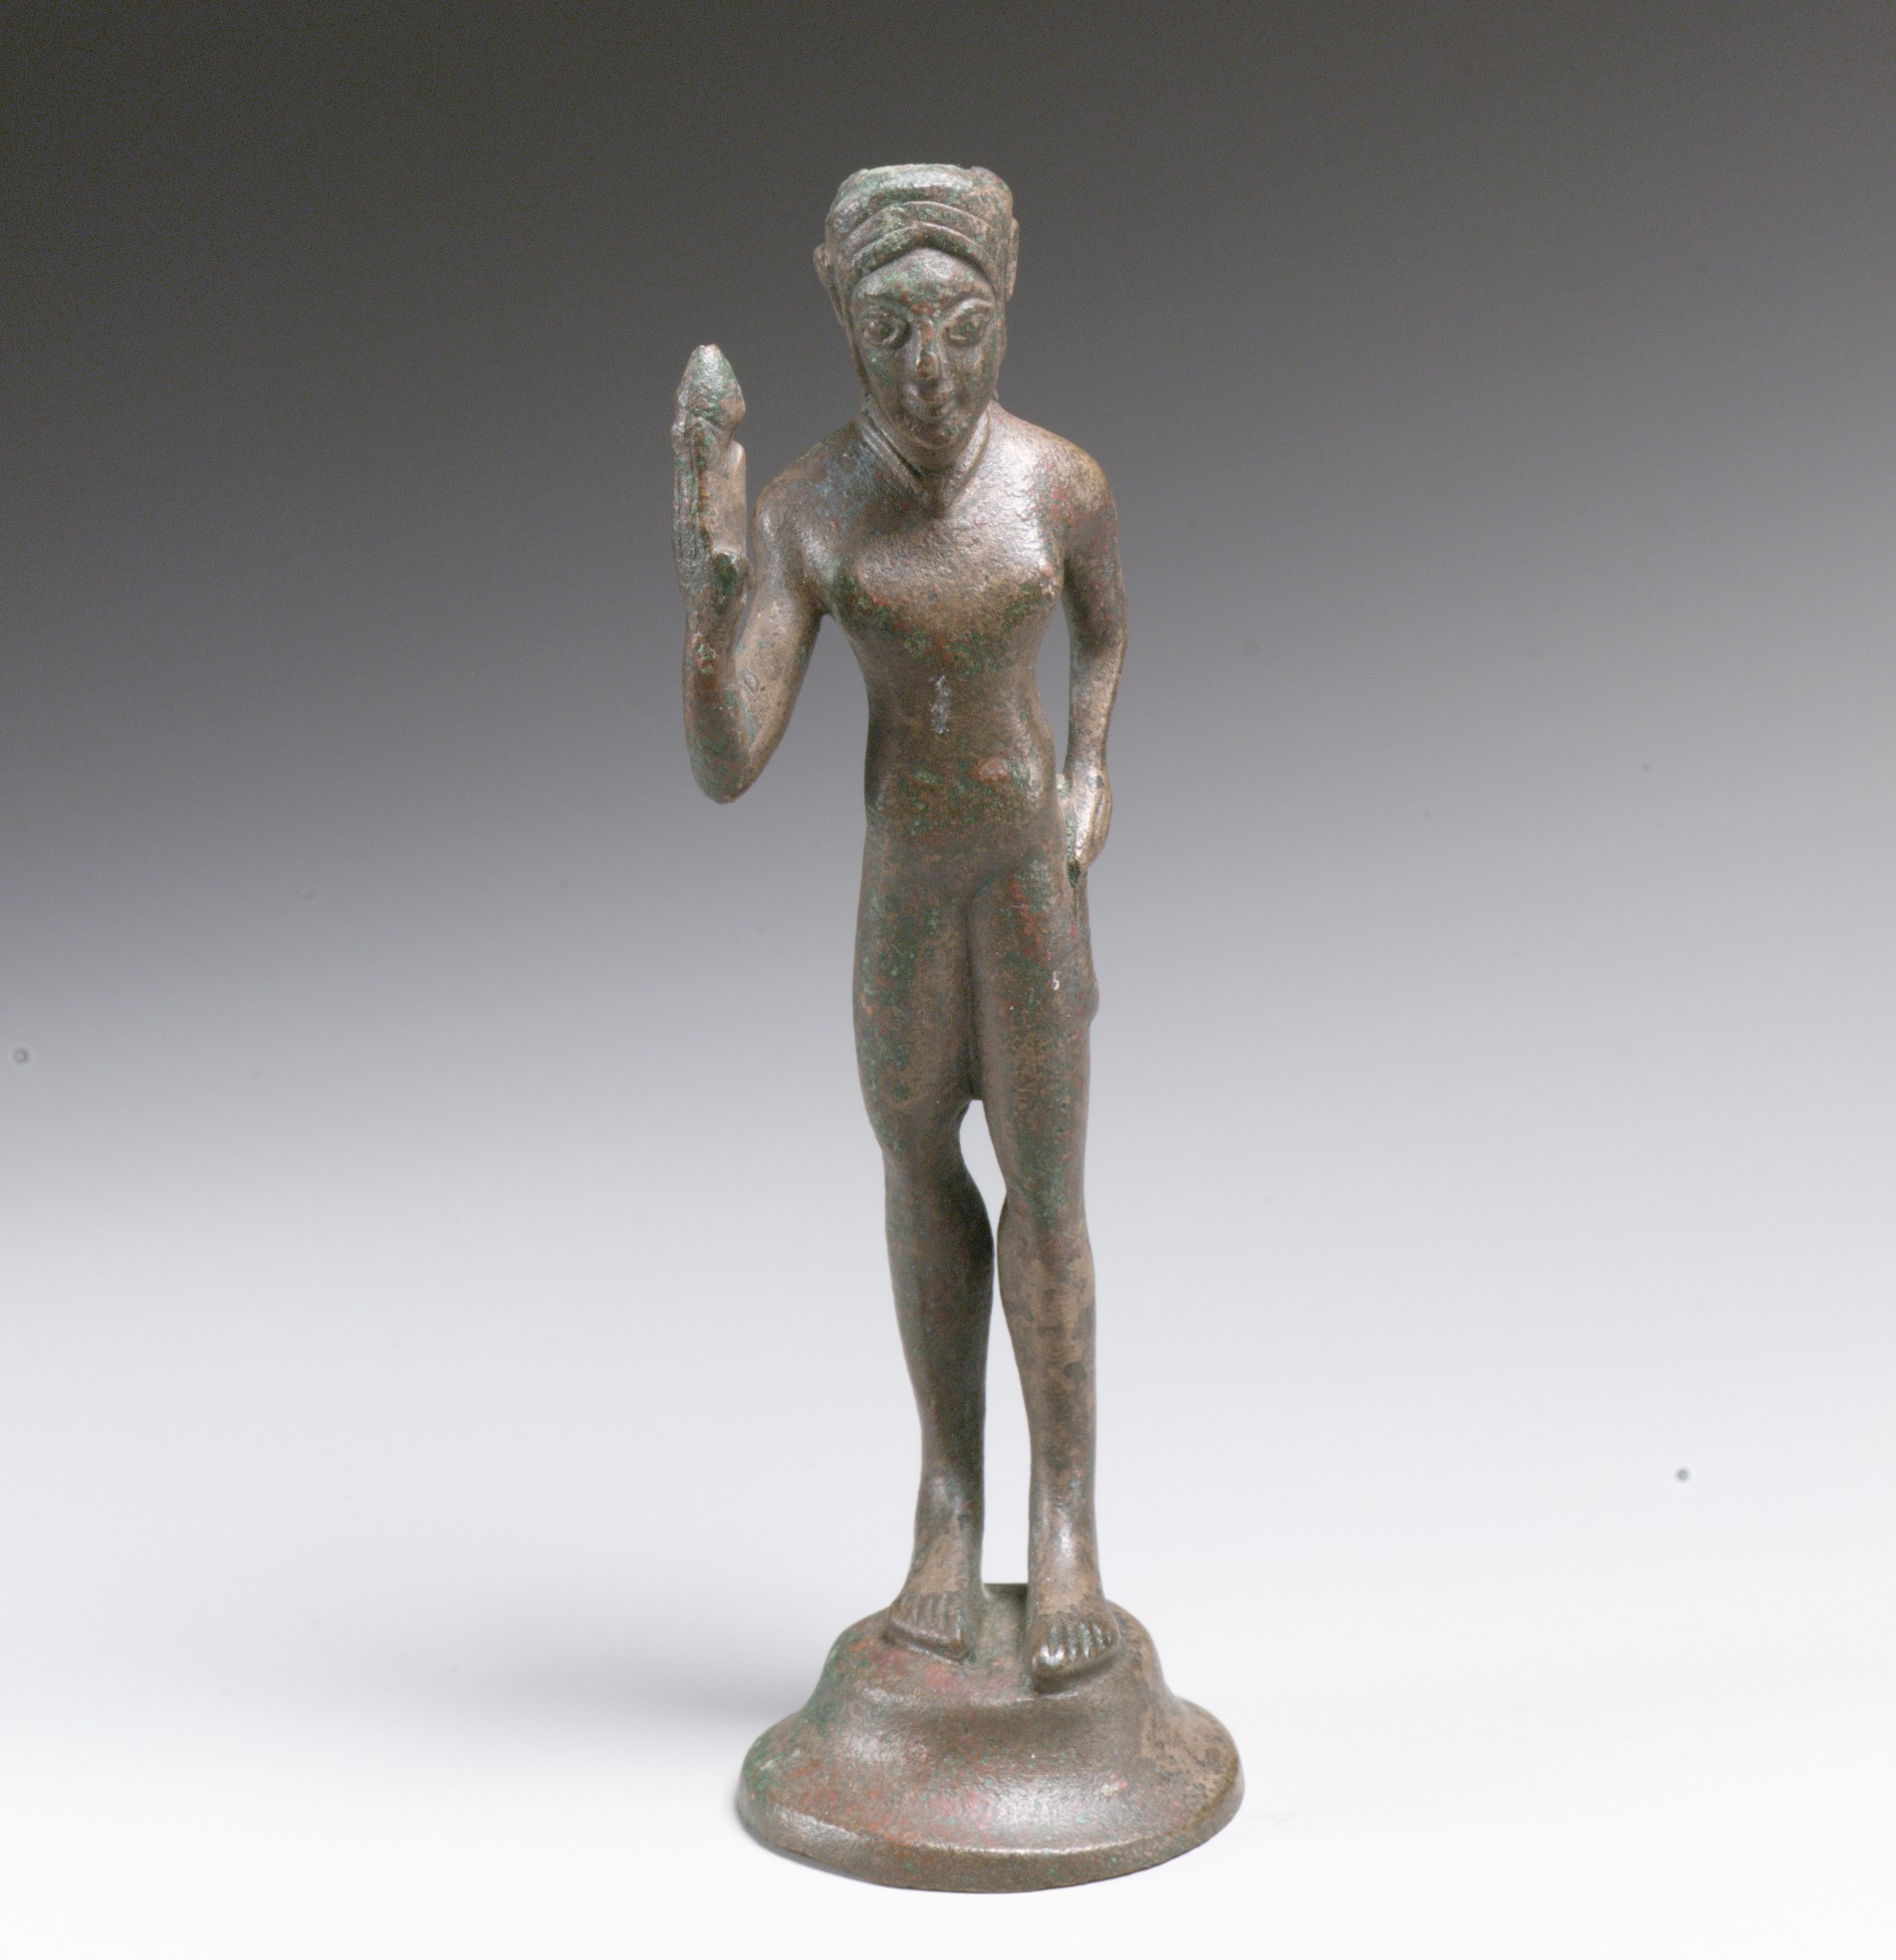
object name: statuette of a girl with lotus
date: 7000 BCE-330 CE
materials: bronze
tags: female nudes,lotuses